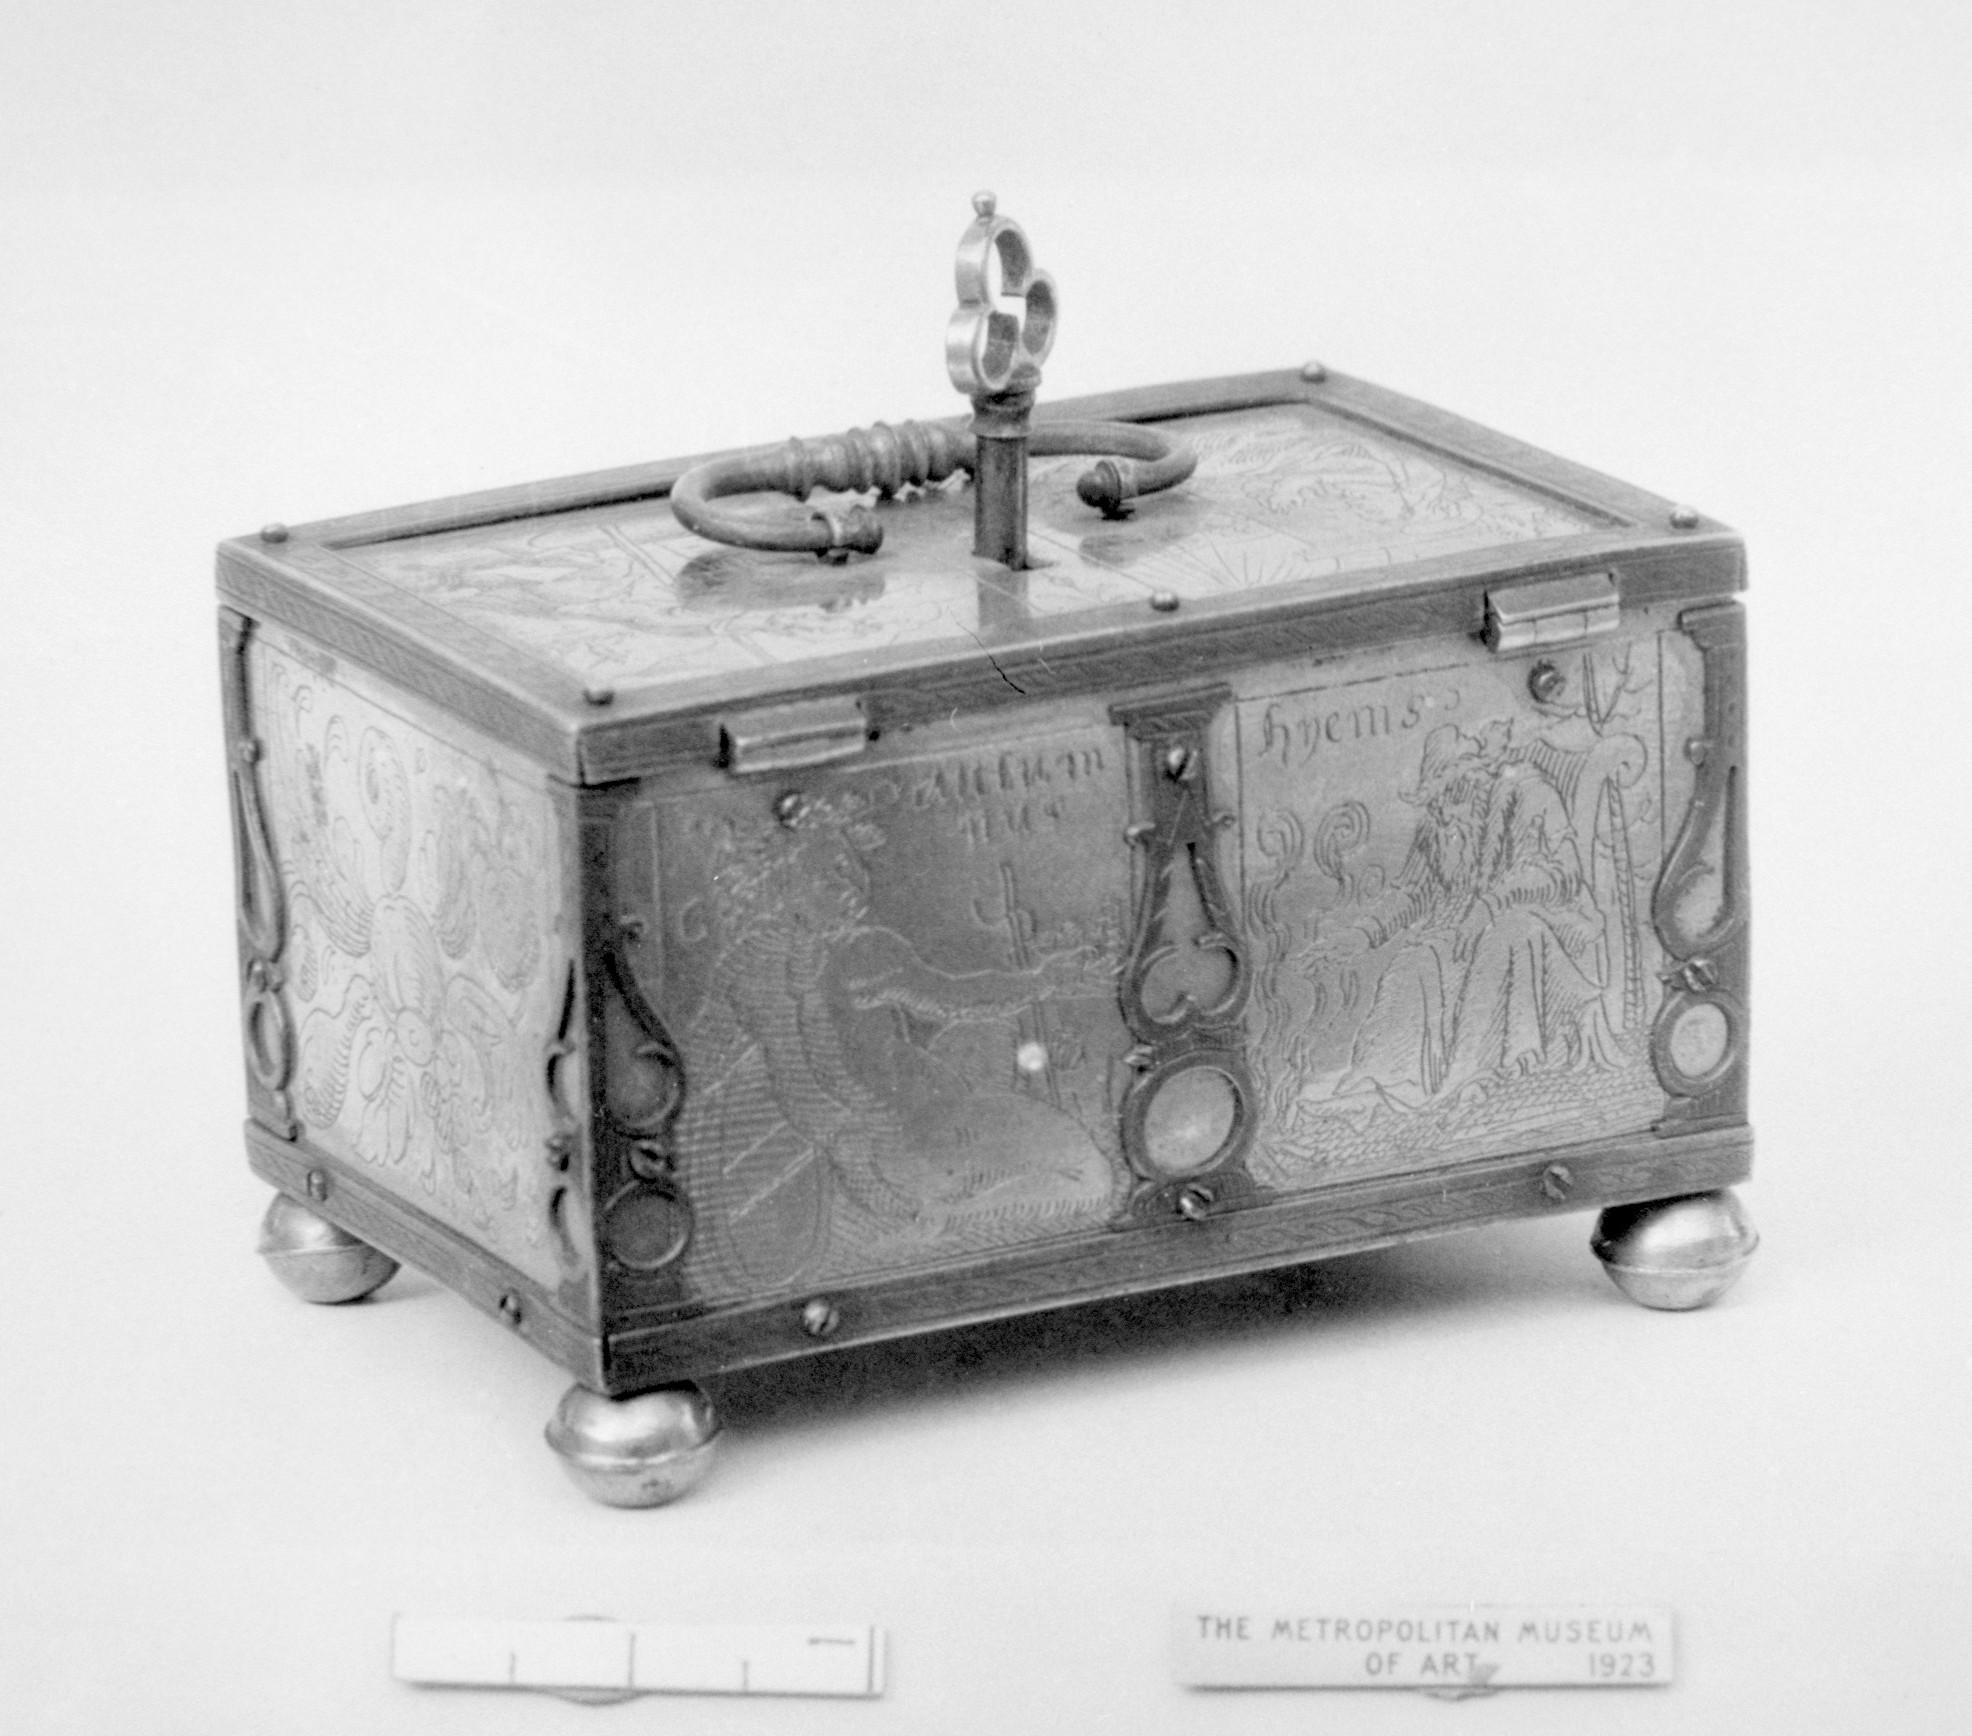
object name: jewel casket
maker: michael mann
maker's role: maker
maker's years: 1530-1630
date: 1601-1700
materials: brass, gilt, silk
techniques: lining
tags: men,women